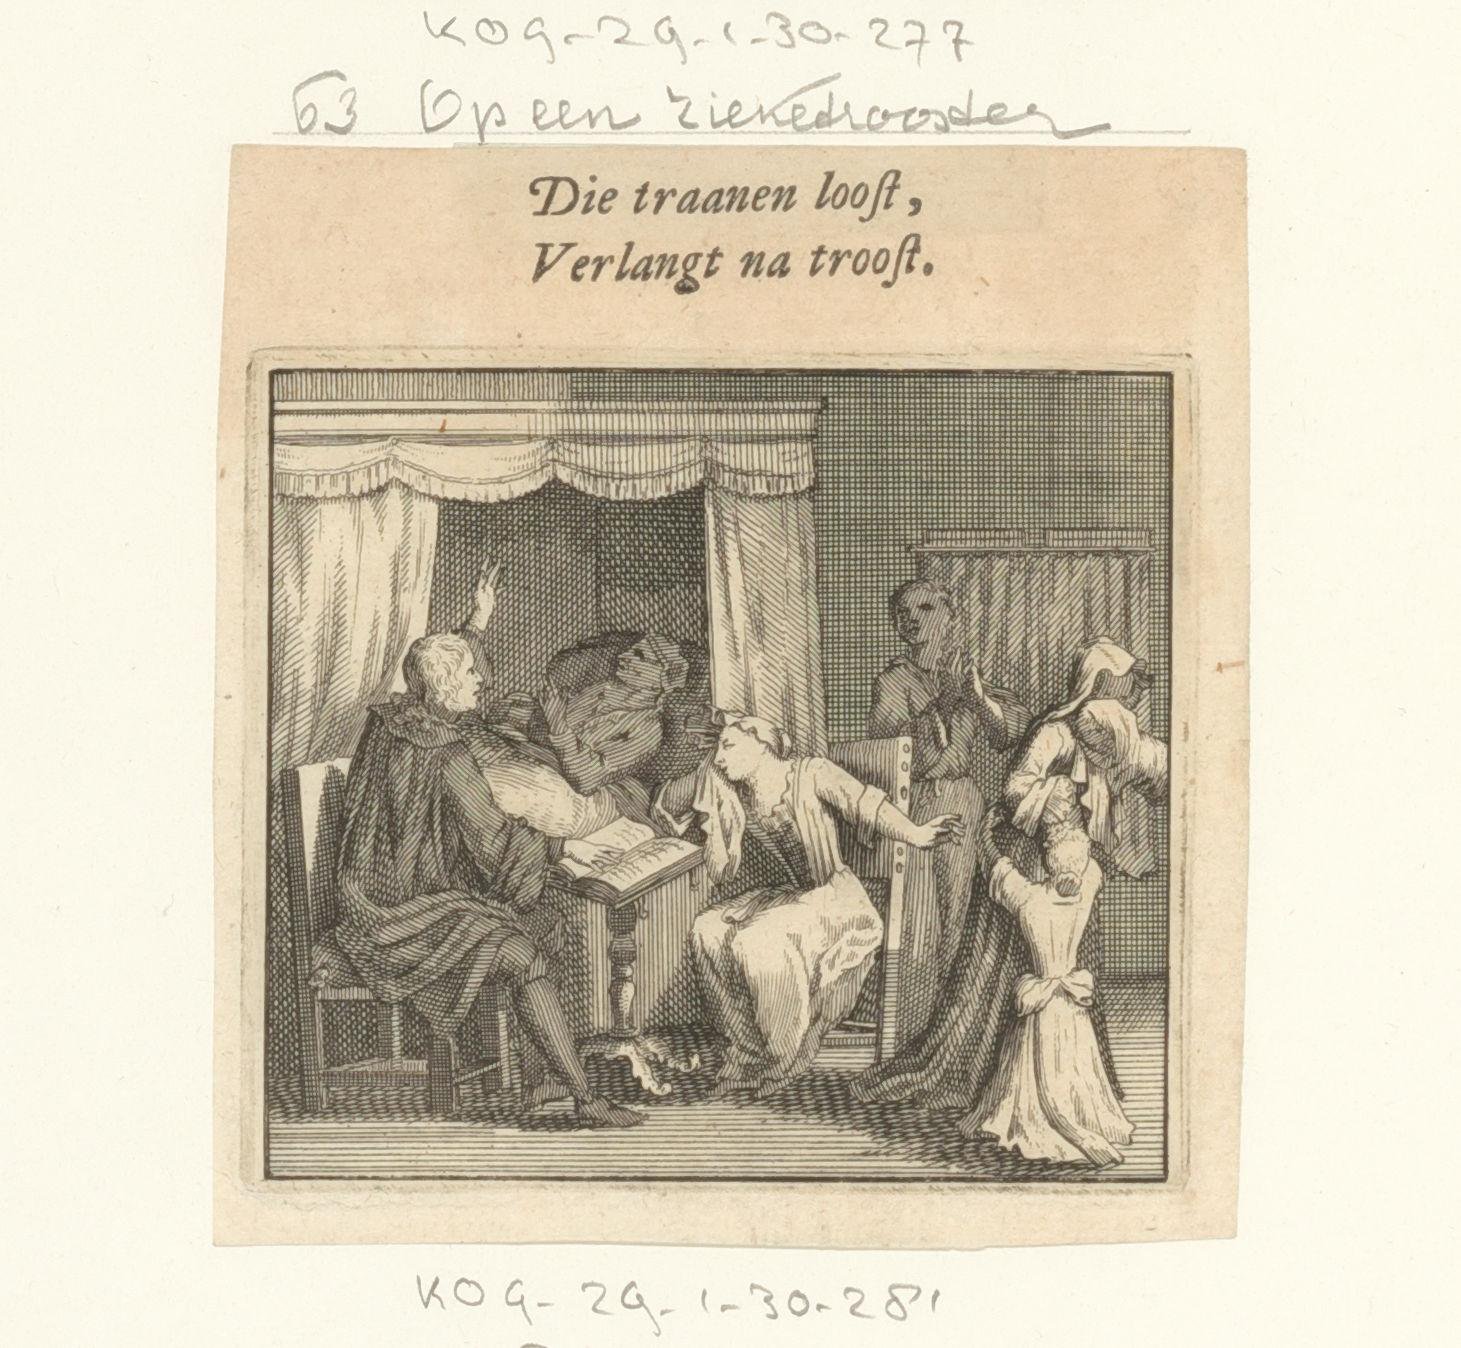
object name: print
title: Die traanen loost, Verlangt na troost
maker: cornelis huyberts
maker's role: print maker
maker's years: 1669-1709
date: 1725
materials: paper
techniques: etching, letterpress printing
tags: deathbed, dying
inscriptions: collector's mark: Lugt 1641, stamp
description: Prent uit: Graauwhart, Hendrik. Voorbeeldelyke zeede-lessen, genoomen uyt den eersten toestand des werelds (...). Amsterdam: Johannes Ratelband, 1725. Prent ook gebruikt voor eerdere en (1709) latere uitgave (1756, 1761 en 1764).